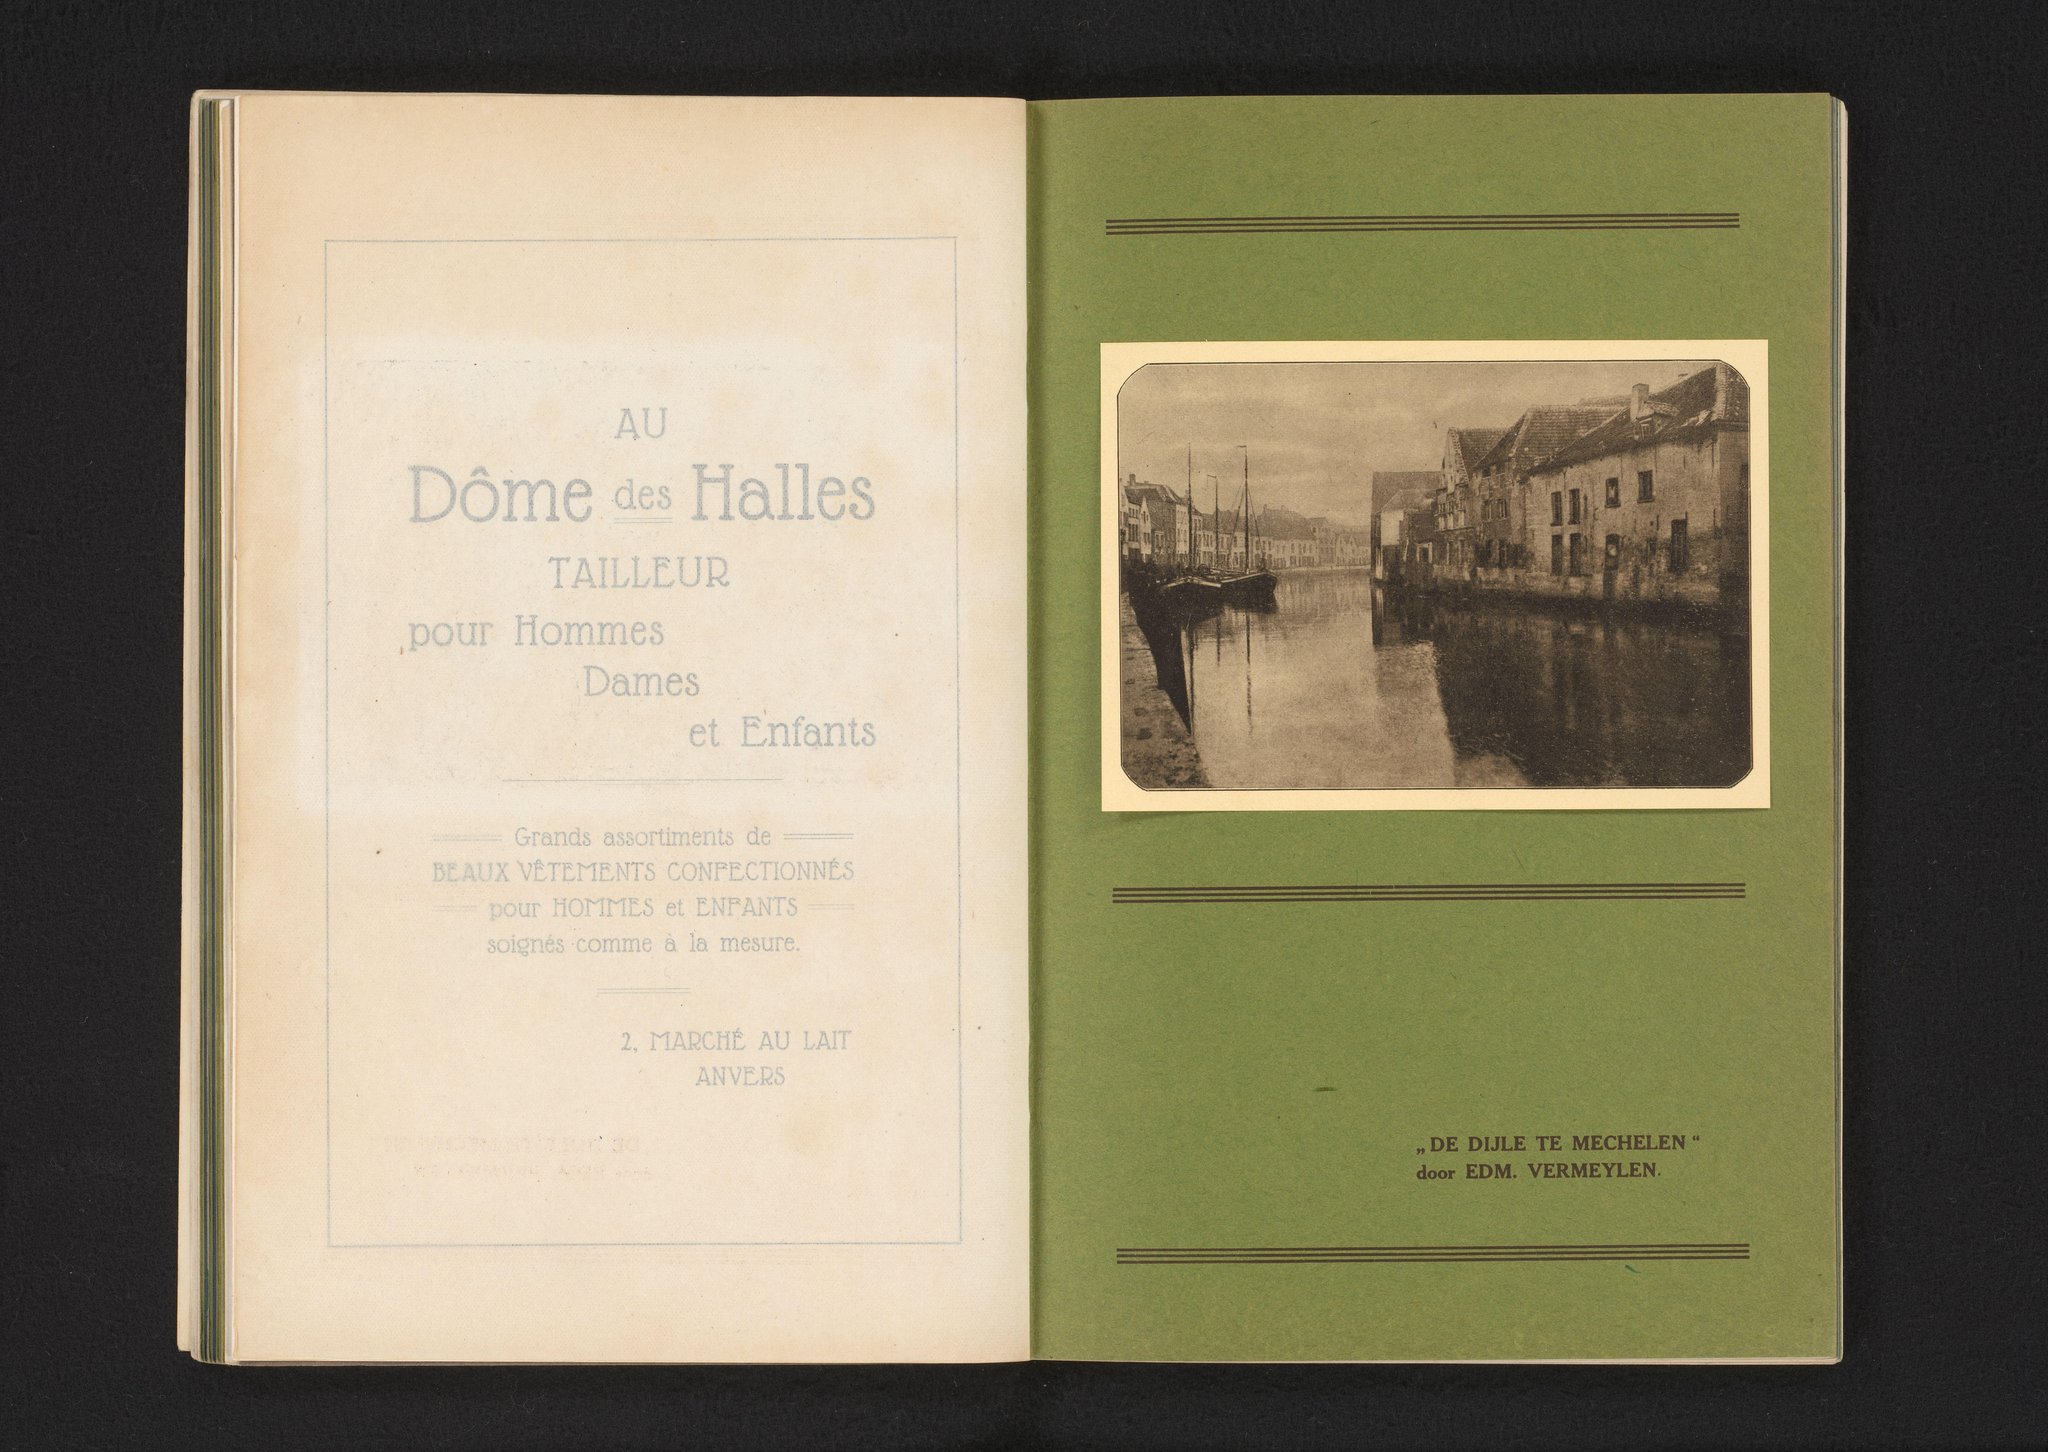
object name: photomechanical print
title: Gezicht op de Dijle te Mechelen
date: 1911-1916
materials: paper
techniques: two-color autotype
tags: sailing-ship, sailing-boat, river, canals, waters (in city), civic architecture; edifices; dwellings, mechelen